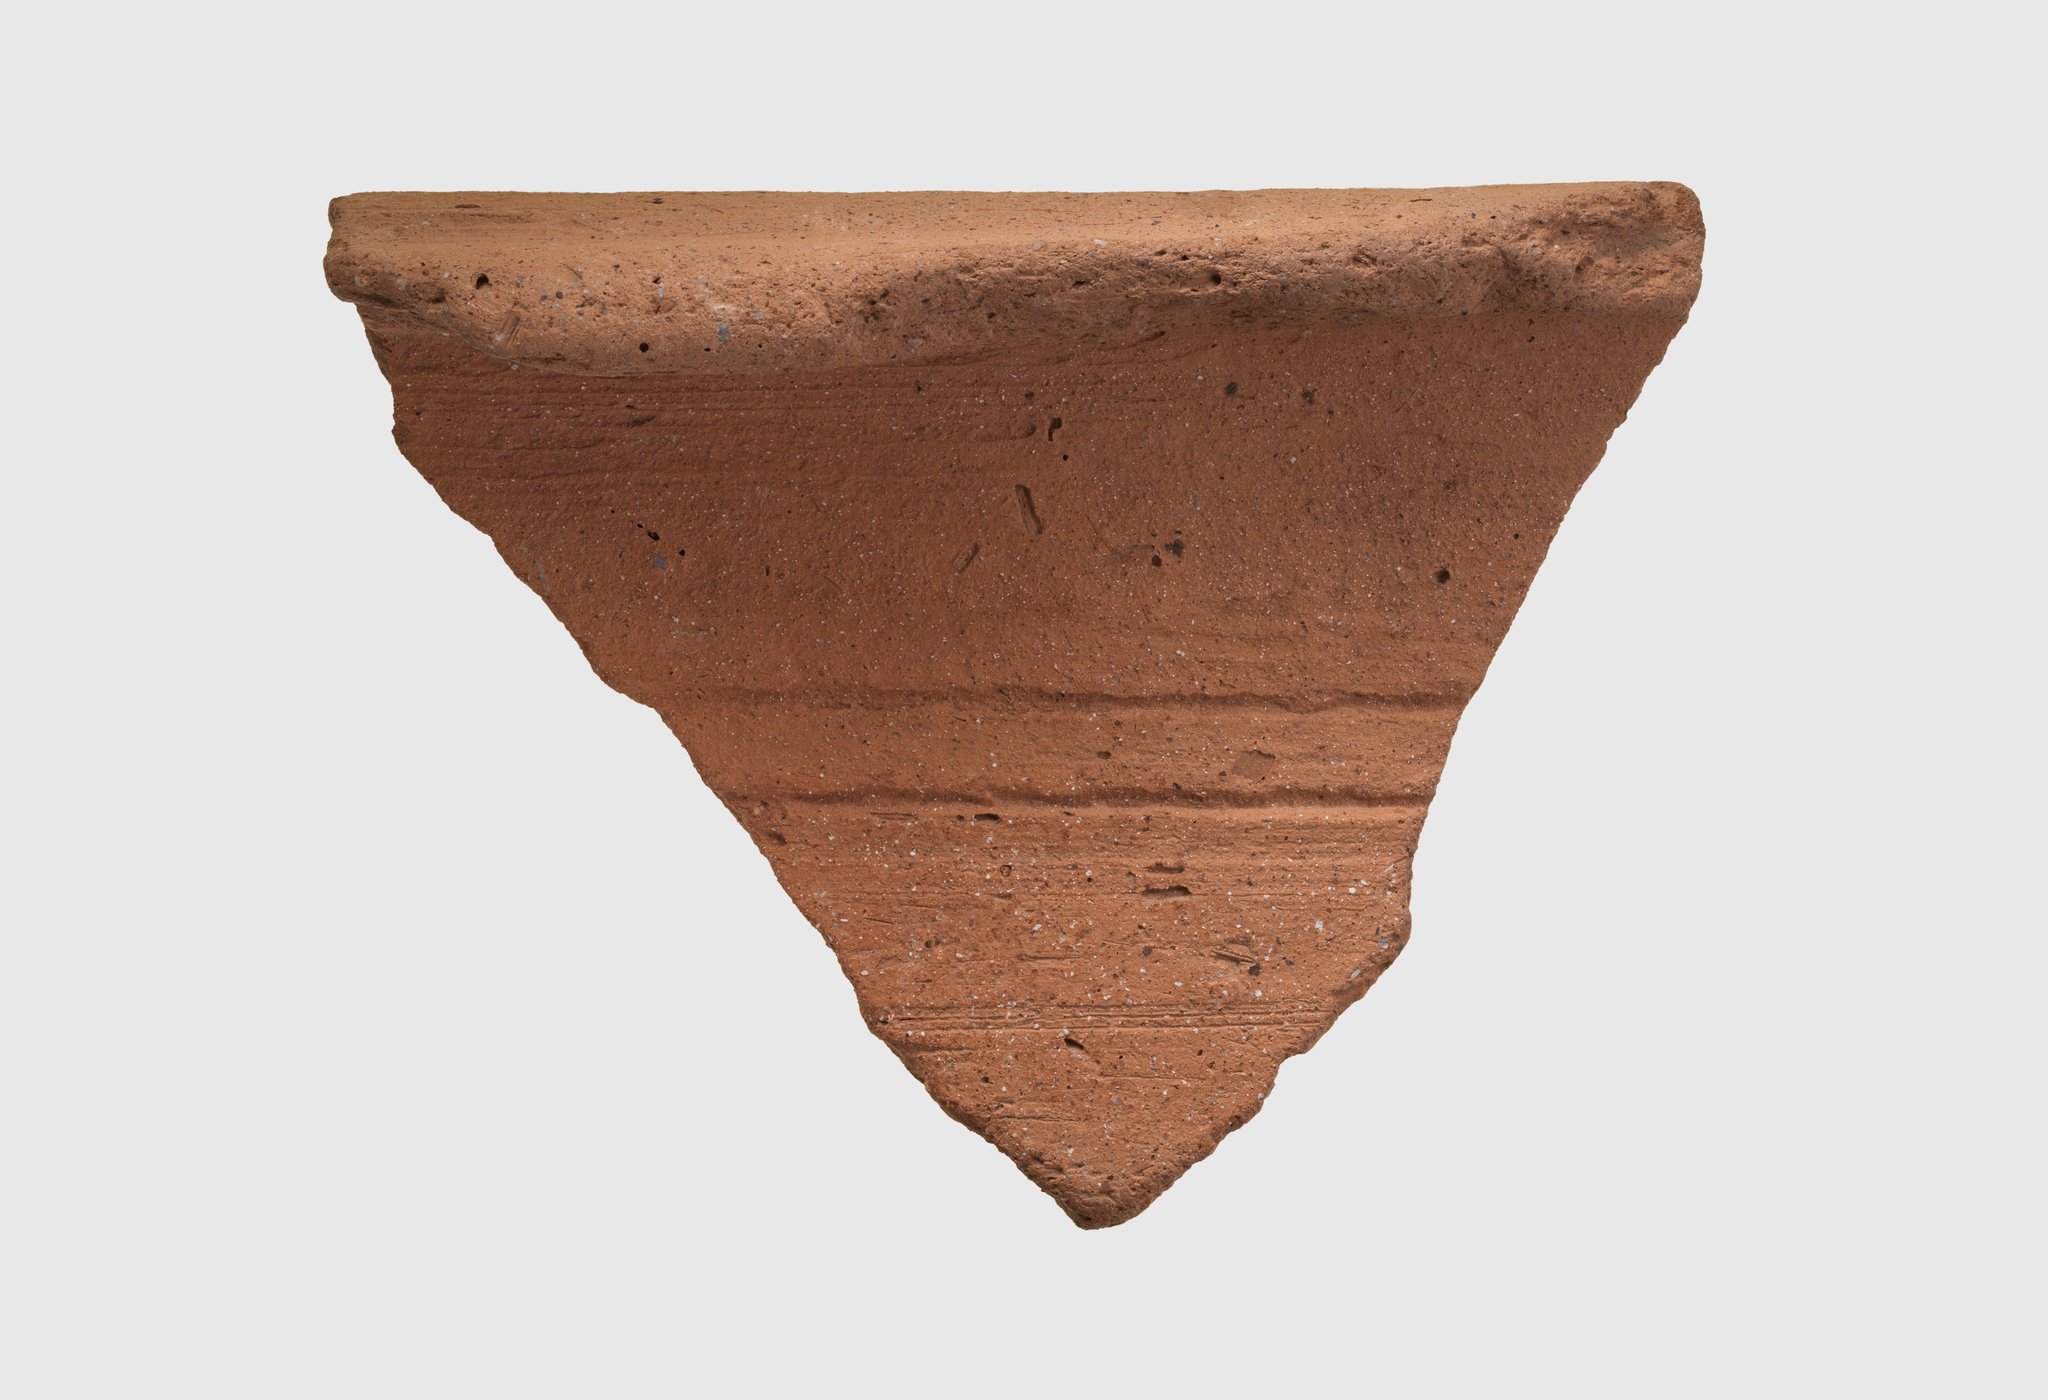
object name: sherd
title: Rim sherd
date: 2333-2001 BCE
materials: ceramic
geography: mesopotamia